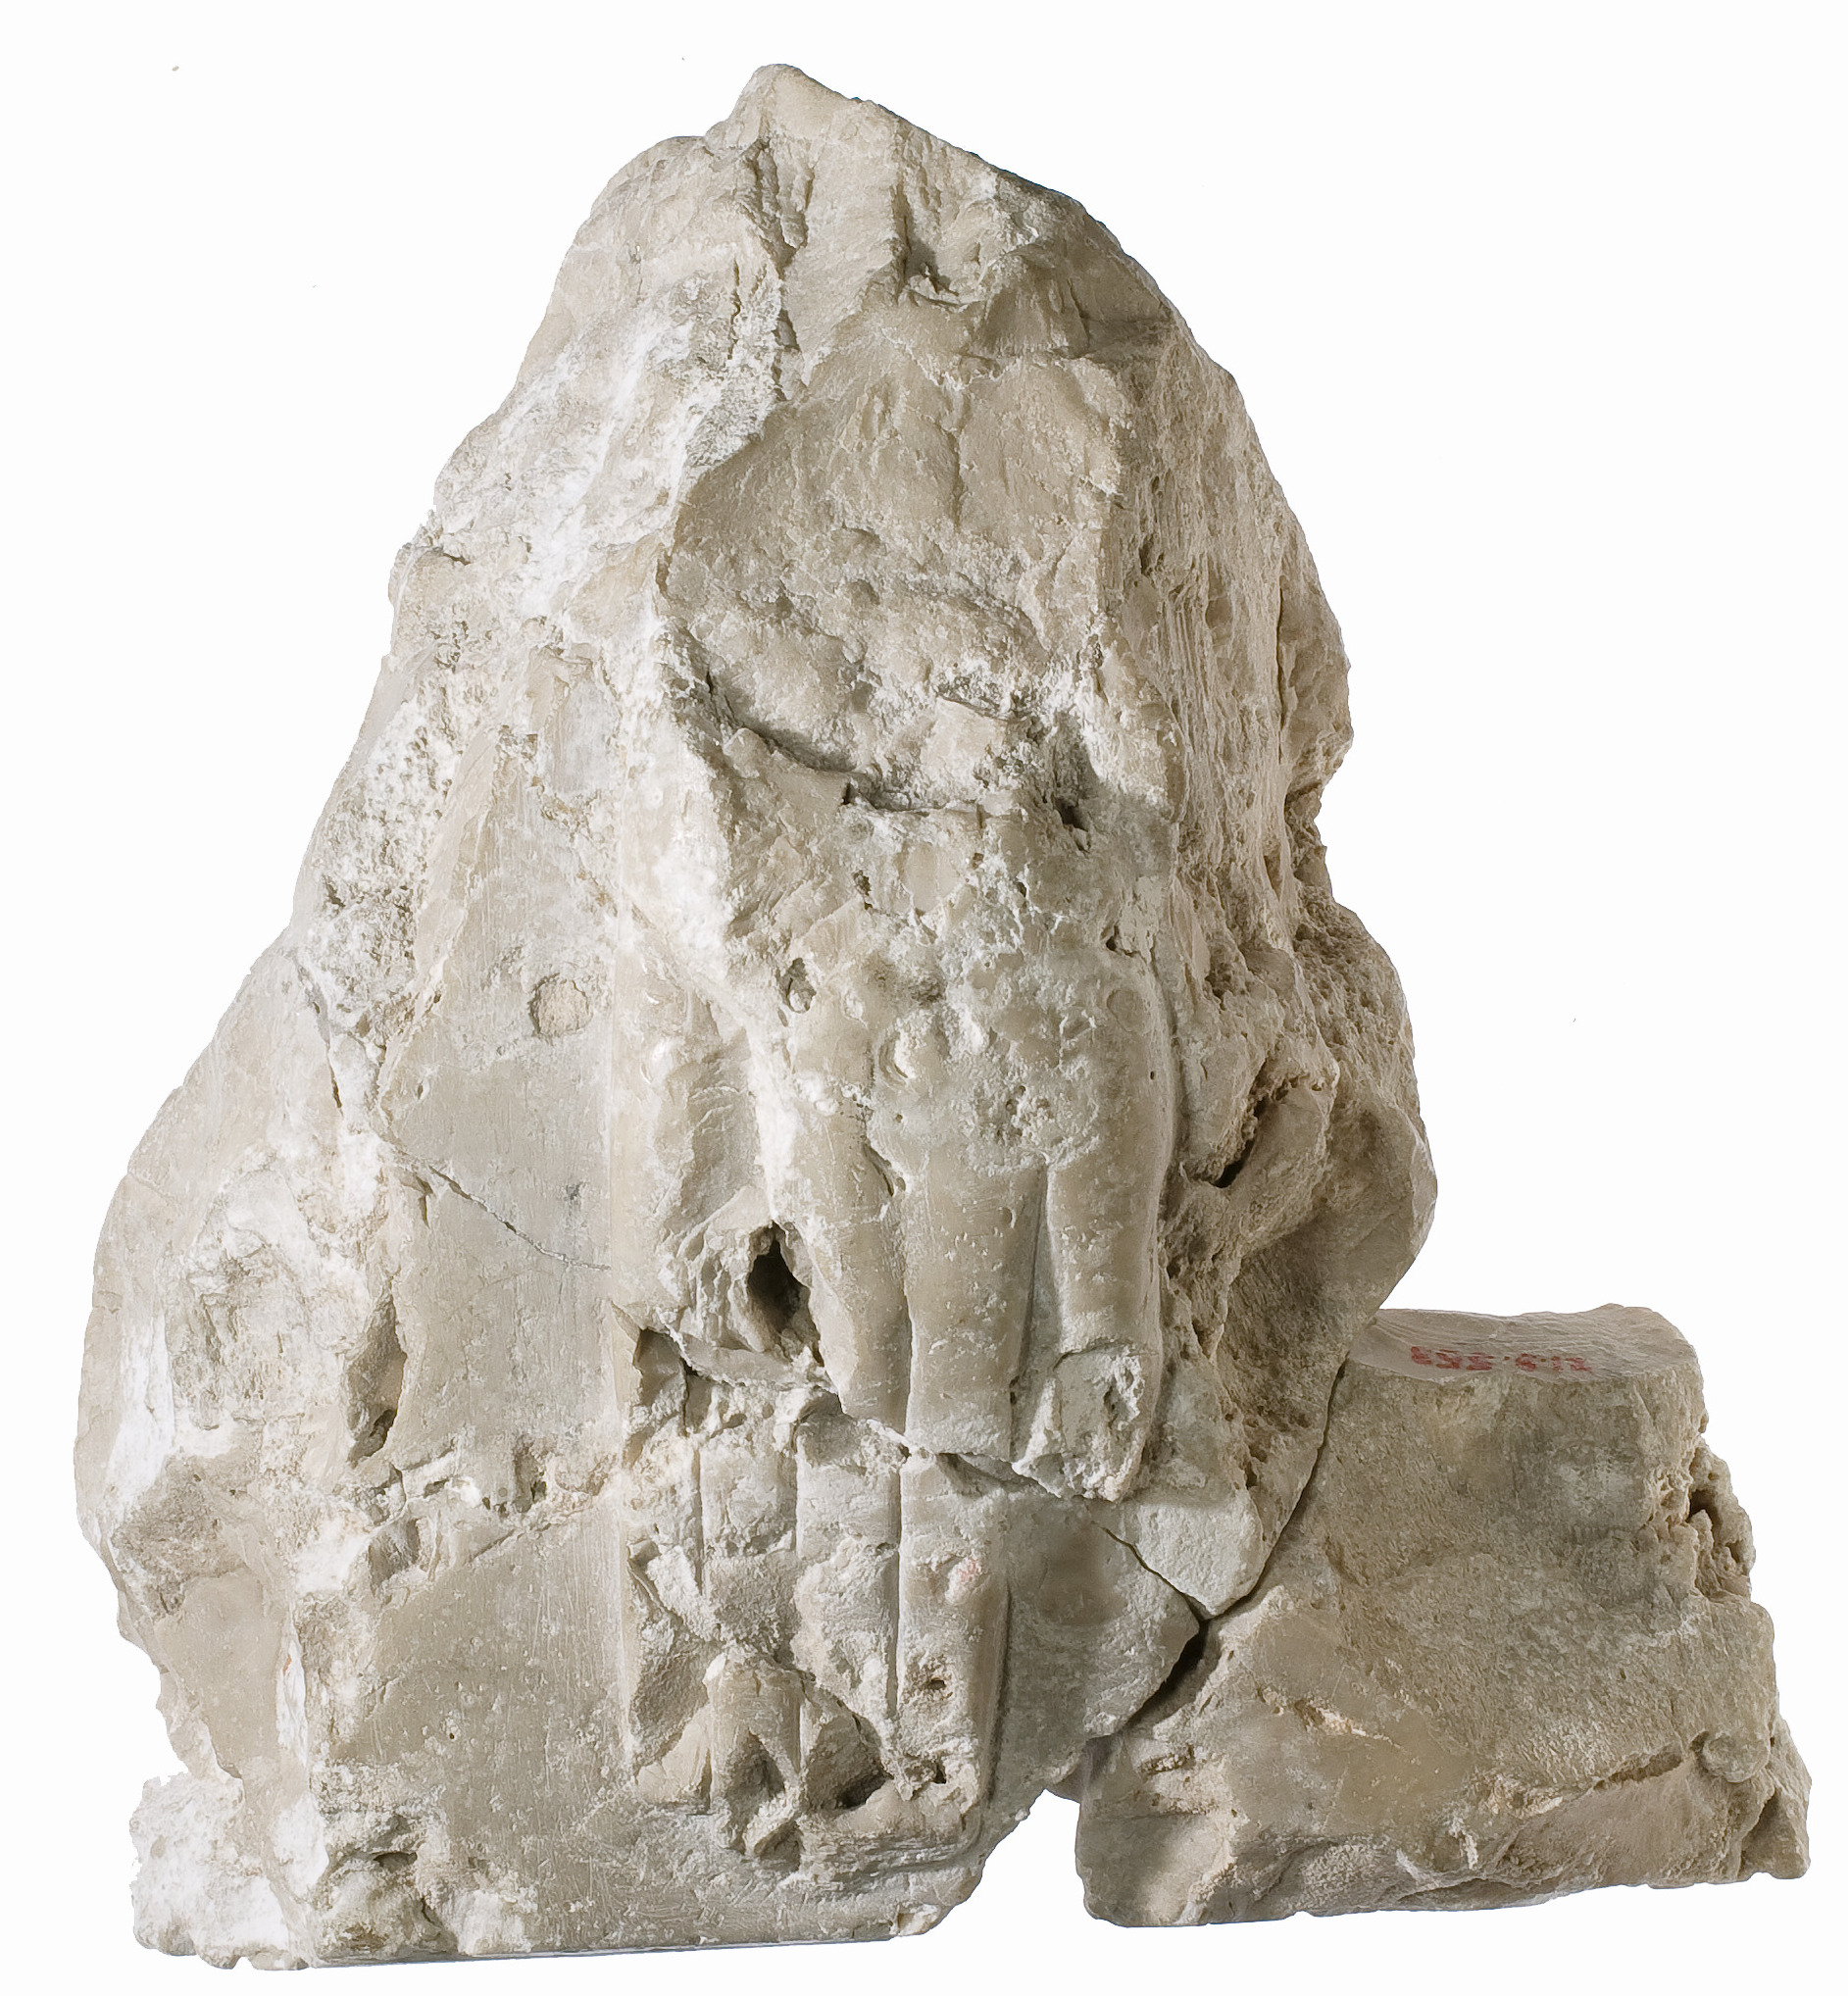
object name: offering table with hand, akhenaten name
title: Offering table with hand, name and titulary of Akhenaten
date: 1353-1336 BCE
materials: limestone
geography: egypt